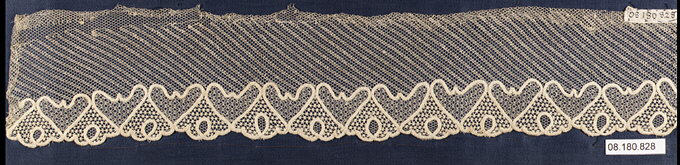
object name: tulle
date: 1801-1900